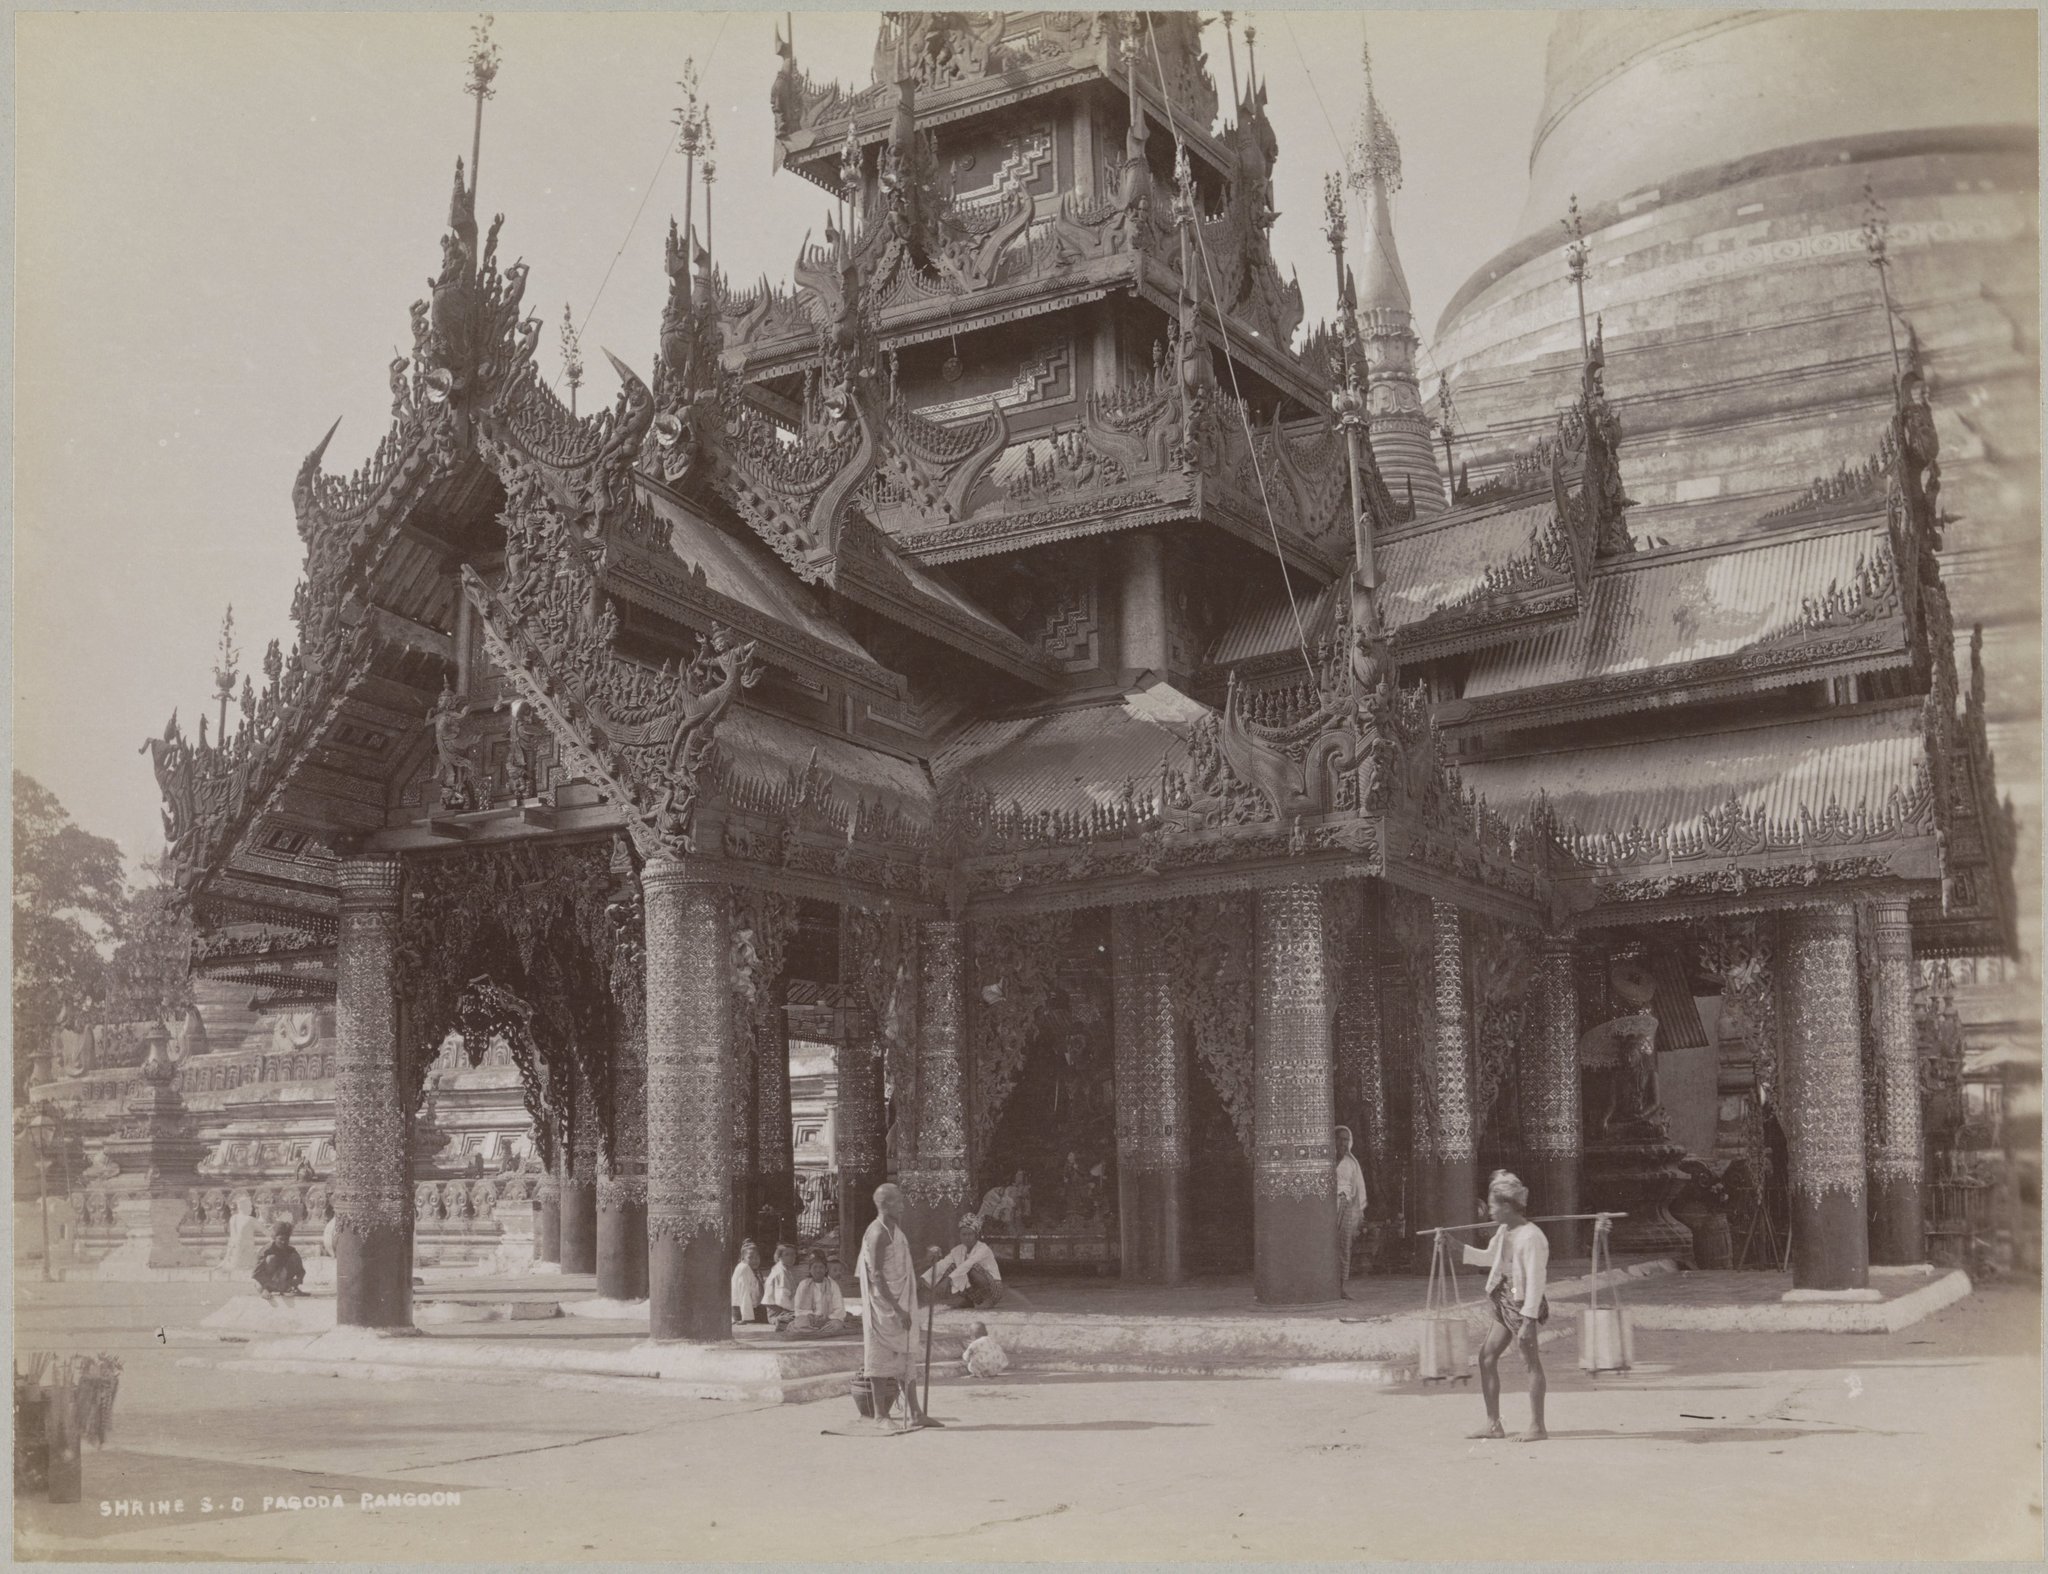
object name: photograph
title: Shwedagon pagoda, Yangon, Myanmar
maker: philip adolphe klier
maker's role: fotograaf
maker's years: 1845-1911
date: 1895-1915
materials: cardboard, paper, photographic support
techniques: albumen print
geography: yangon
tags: yangon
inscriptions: number: ‘3.’, title: ‘Shrine S. D. Pagoda Rangoon’